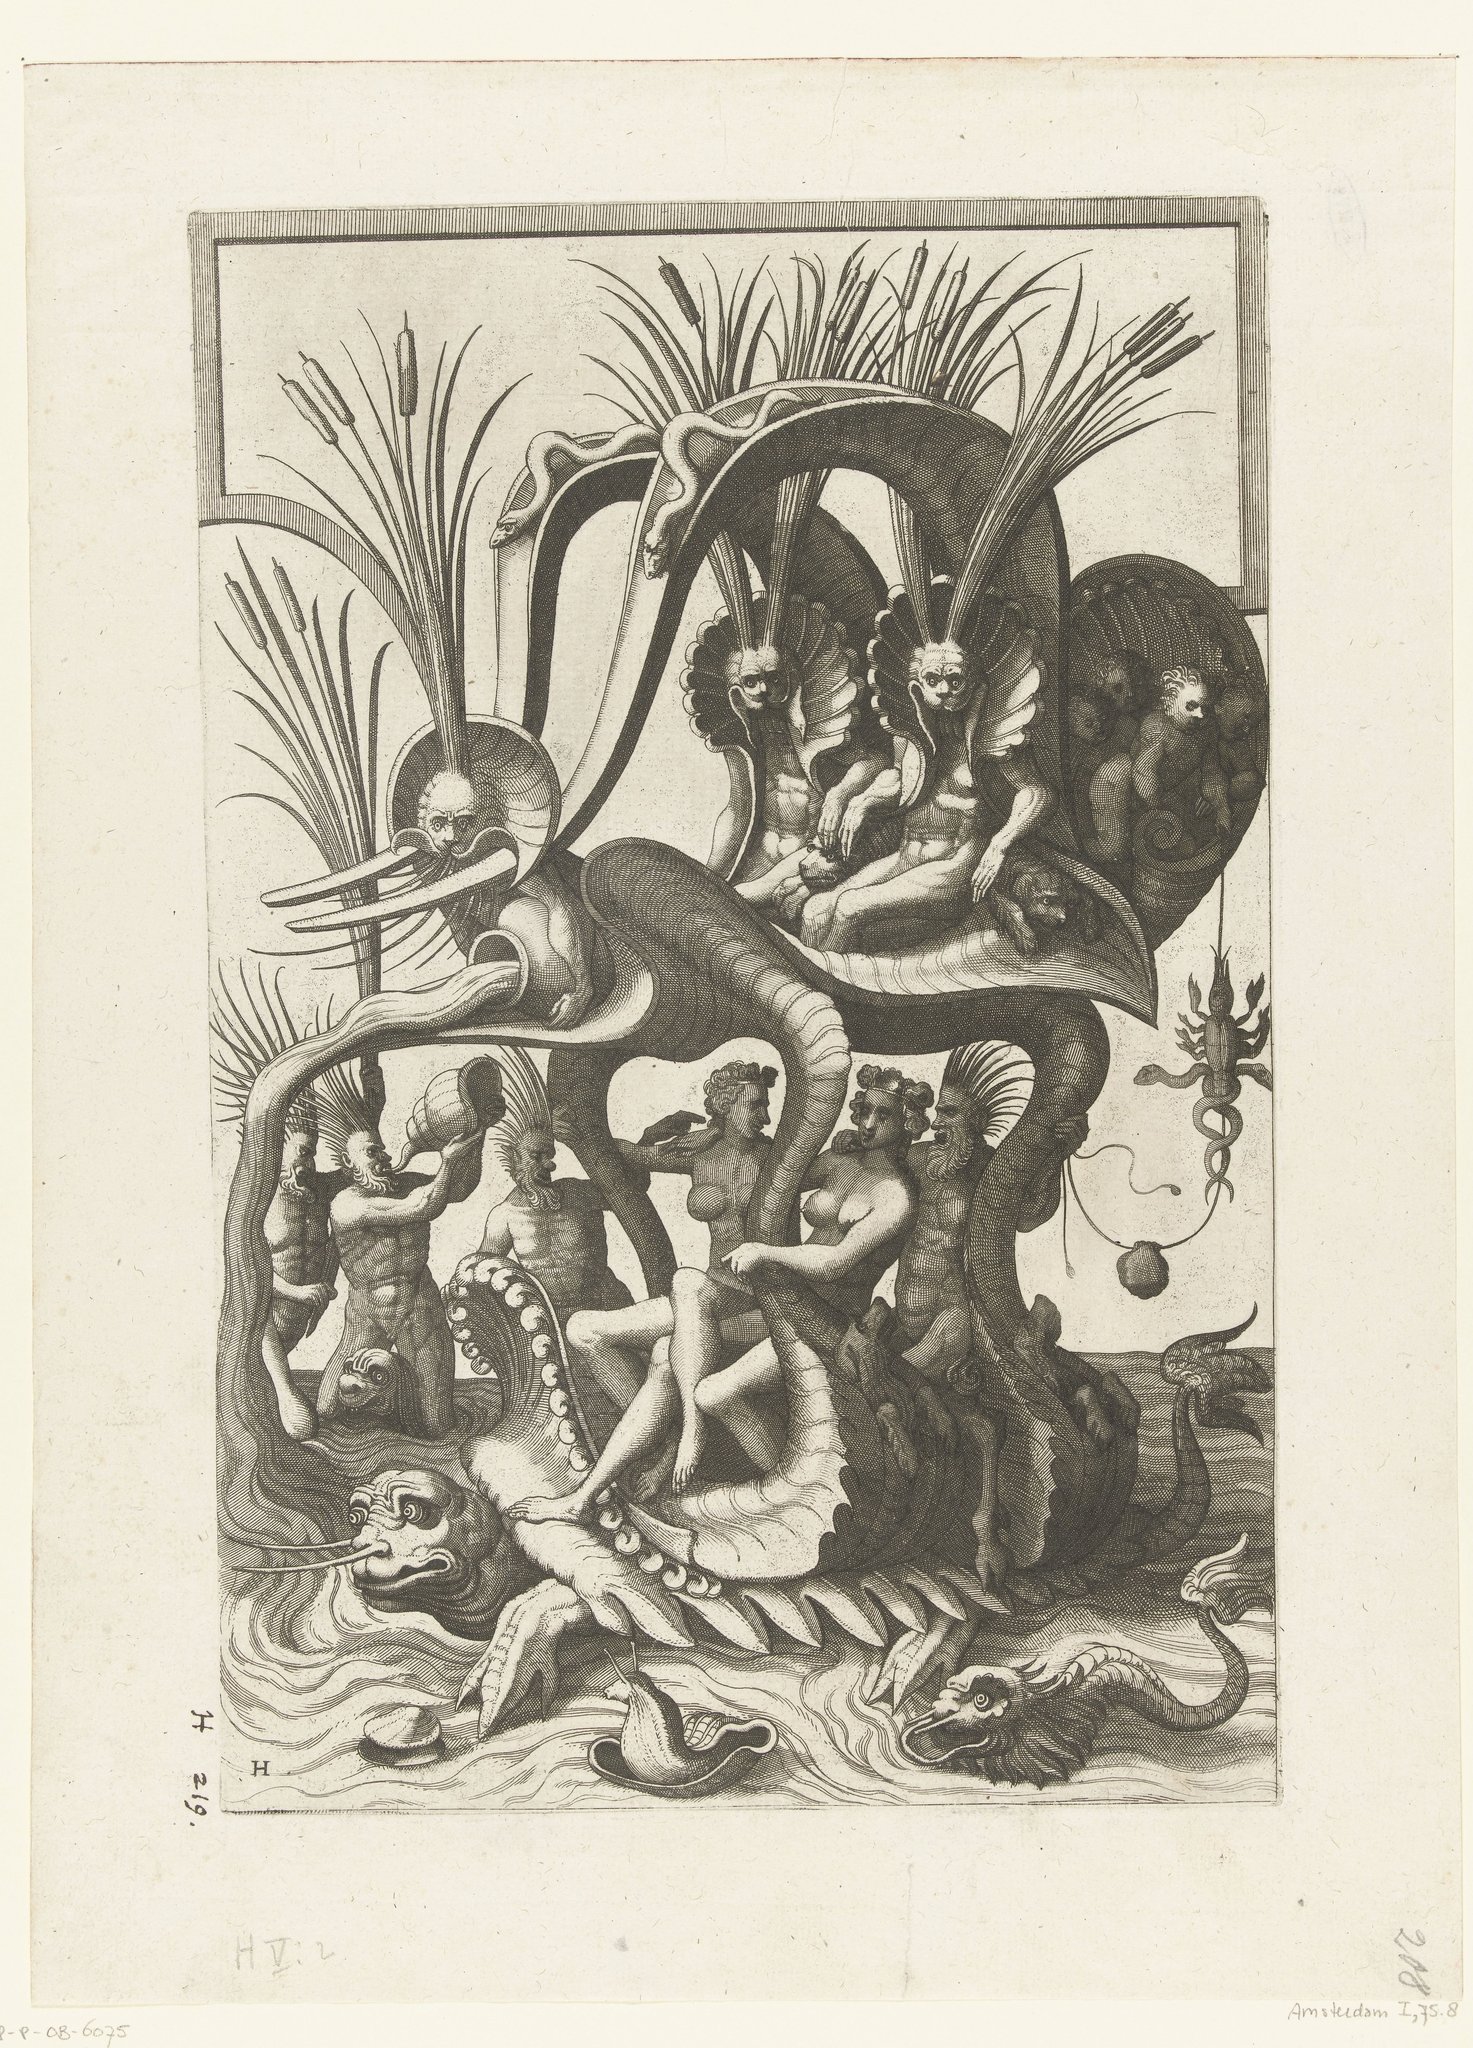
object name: ornament print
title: Veelderleij Veranderinghe van grotissen ende Compertimenten (...)Libro Primo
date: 1556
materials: paper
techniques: etching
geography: netherlands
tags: ornament ~ grotesque, tortoises, turtles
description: In de wagen zitten twee vrouwen en een sater. Boven hen zitten twee figuren met schelpvormige kragen en lisdodden op hun hoofd. Blad H uit serie van 12 bladen, genummerd A-M met vlakdecoraties van grotesken met rolwerk, saters, guirlandes, trofeeën, dieren en fantasiewezens